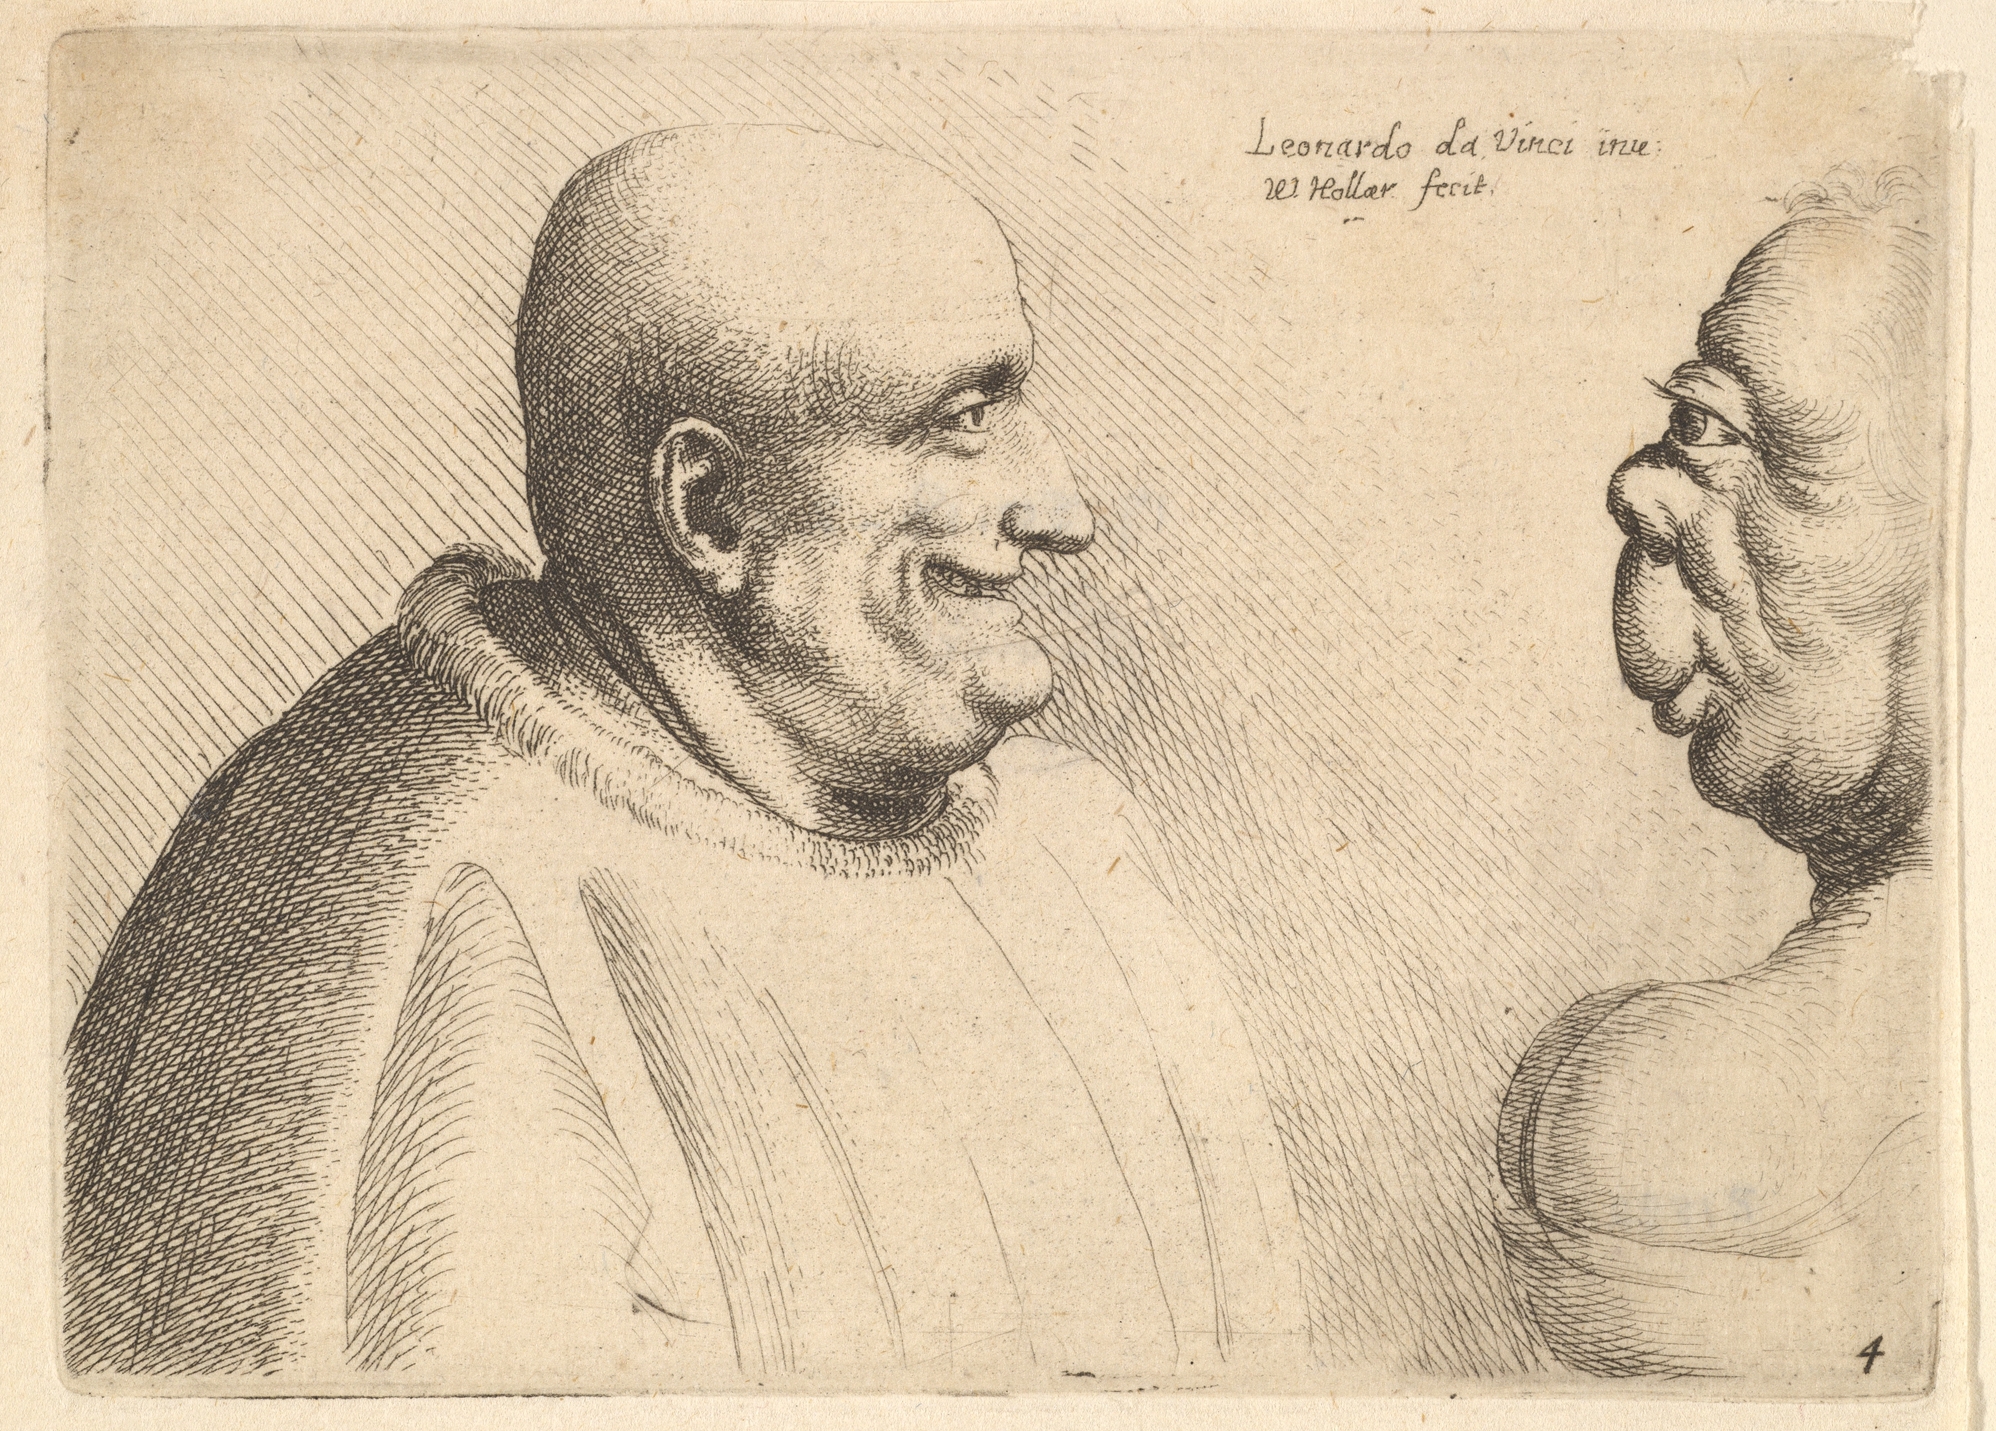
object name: print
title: A large man with a bald head facing a grotesque female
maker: wenceslaus hollar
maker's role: artist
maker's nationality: bohemian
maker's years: 1607-1677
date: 1645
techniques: etching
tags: men,profiles,women